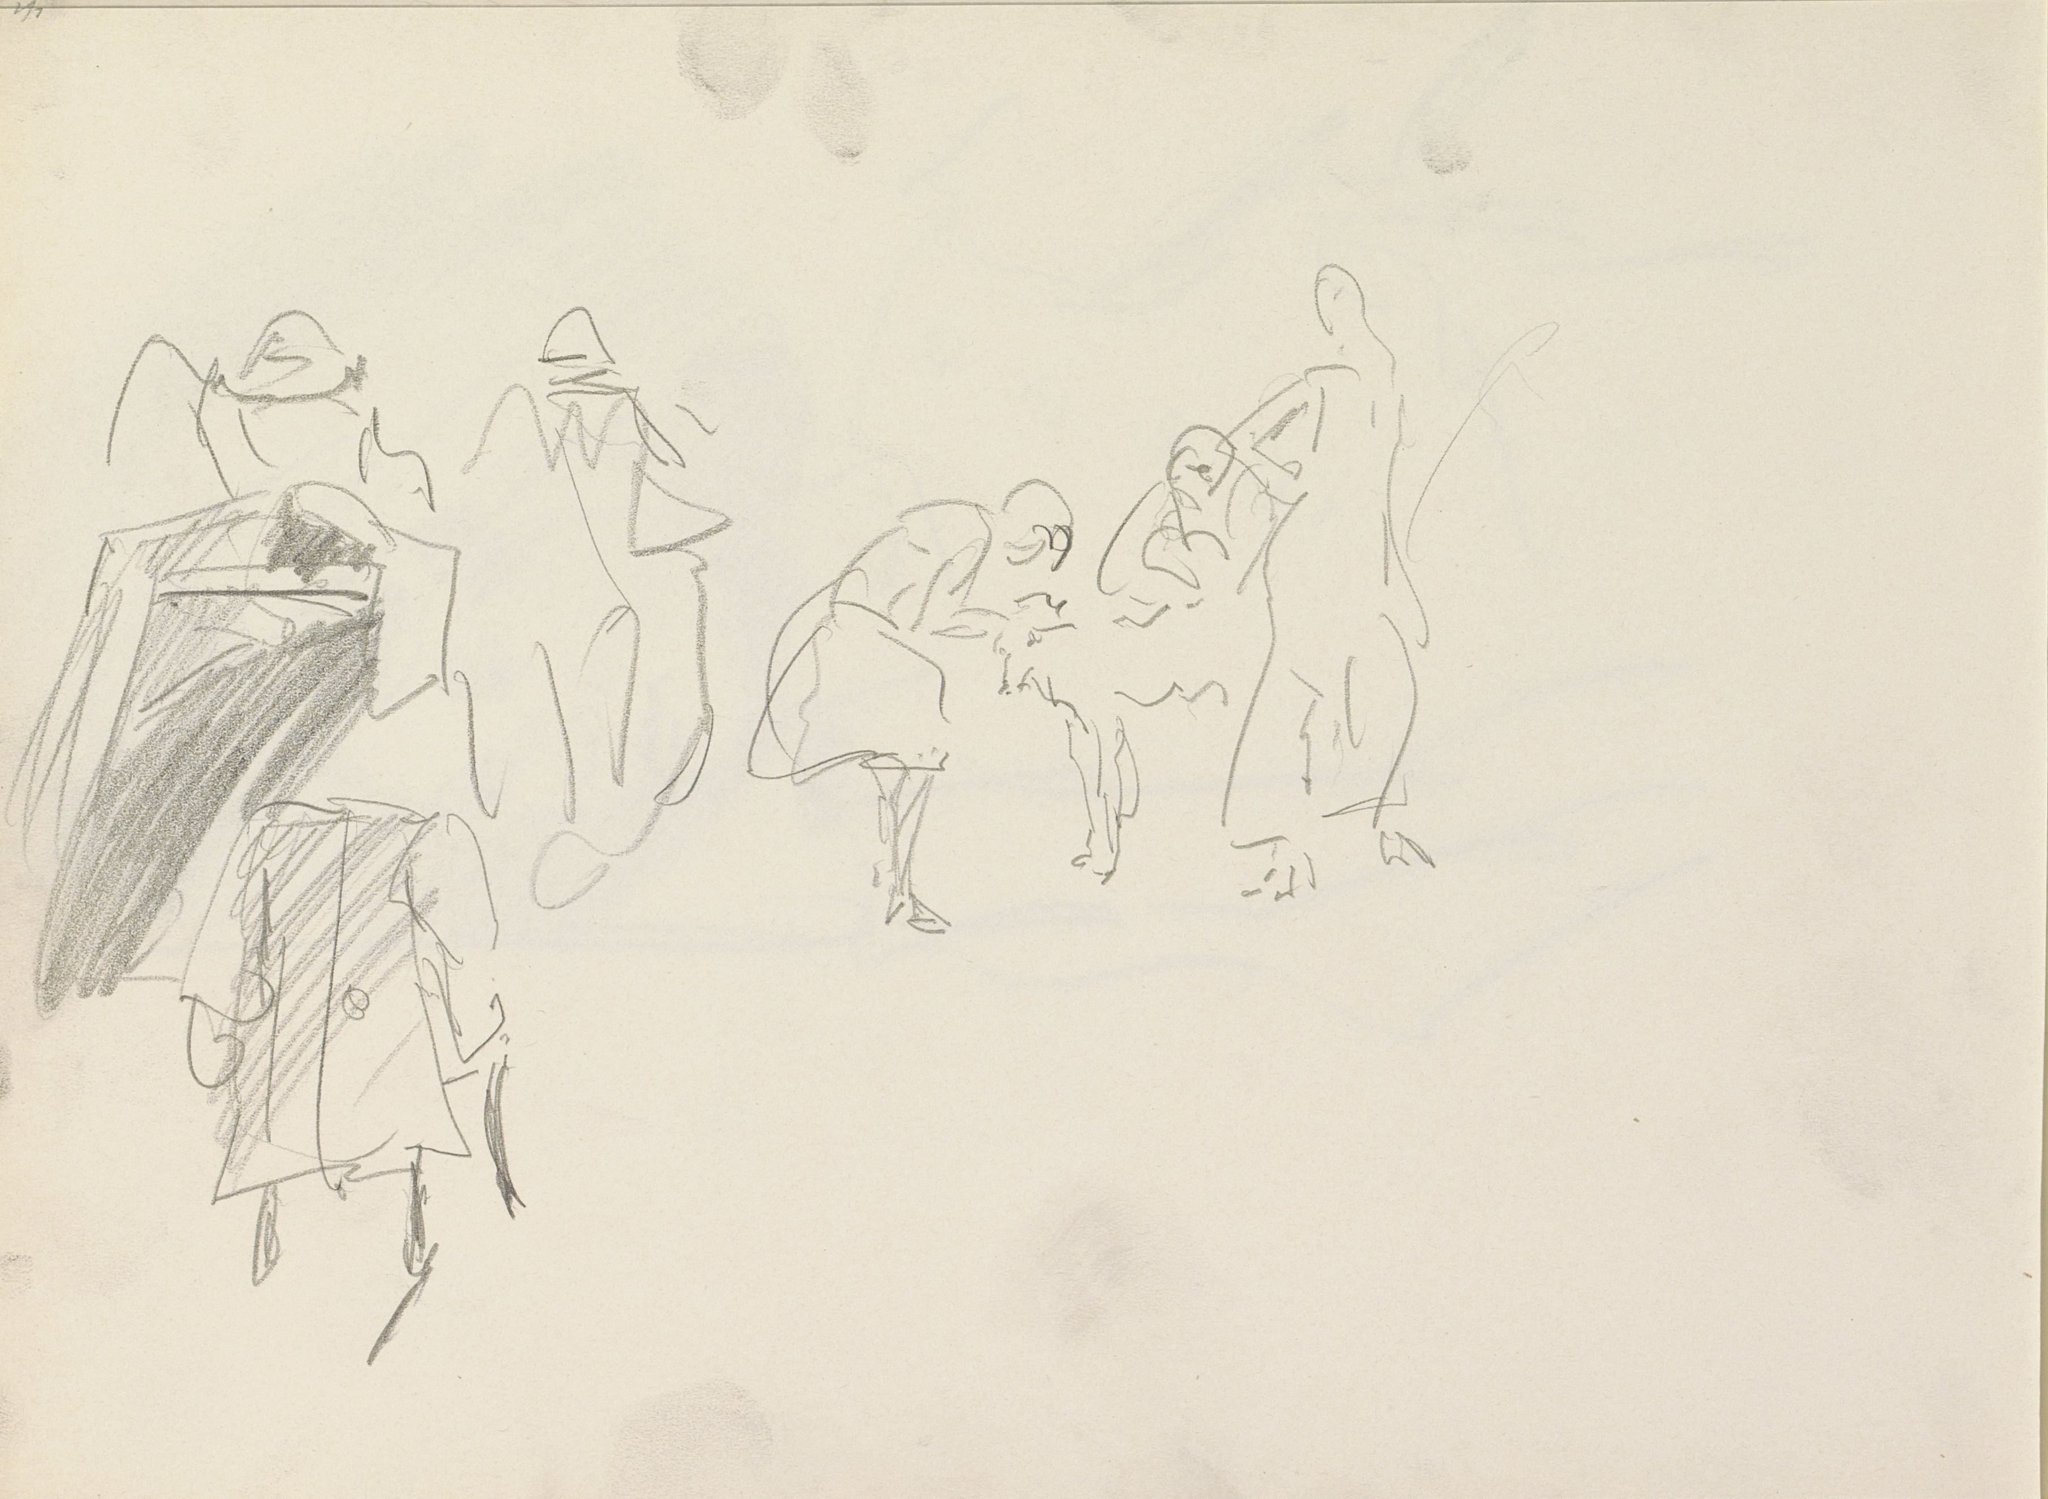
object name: sketchbook leaf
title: Figuurstudies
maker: isaac israels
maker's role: draughtsman, painter, print maker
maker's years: 1865-1934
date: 1875-1934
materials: paper, pencil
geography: the hague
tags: the (nude) human figure; 'corpo humano' (ripa) (+ positions (of the human figure))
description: Blad 26 verso uit schetsboek V met 33 bladen.